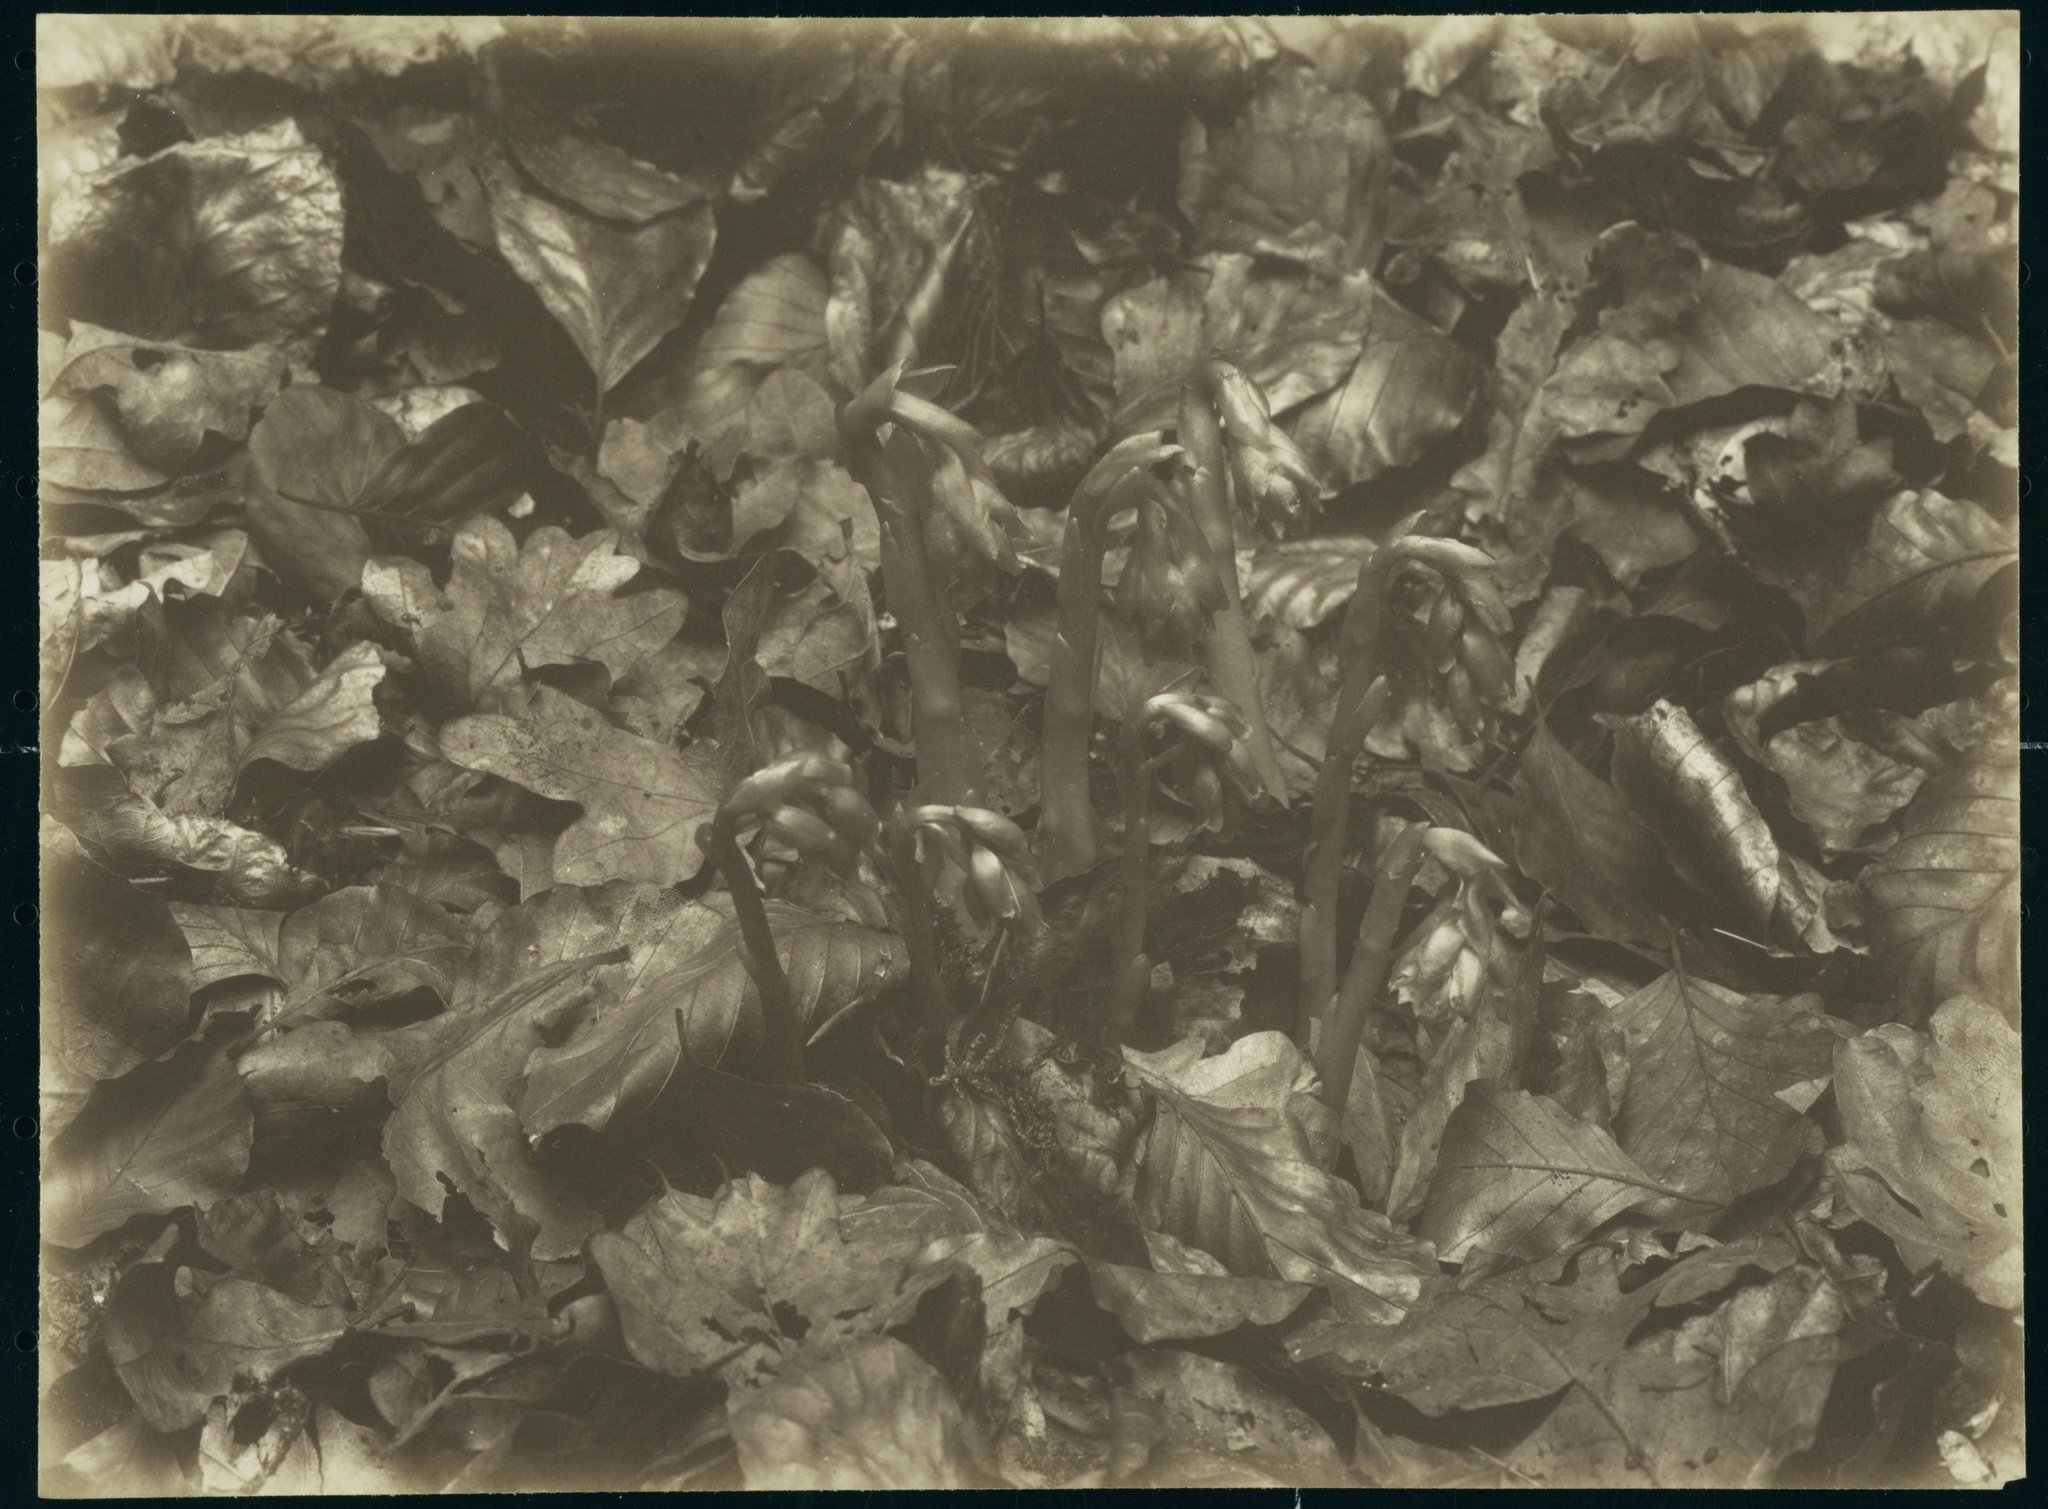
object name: photograph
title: Sneeuwklokjes tussen bladeren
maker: richard tepe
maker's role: fotograaf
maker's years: 1864-1952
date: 1900-1930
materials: photographic support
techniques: gelatin silver print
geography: netherlands